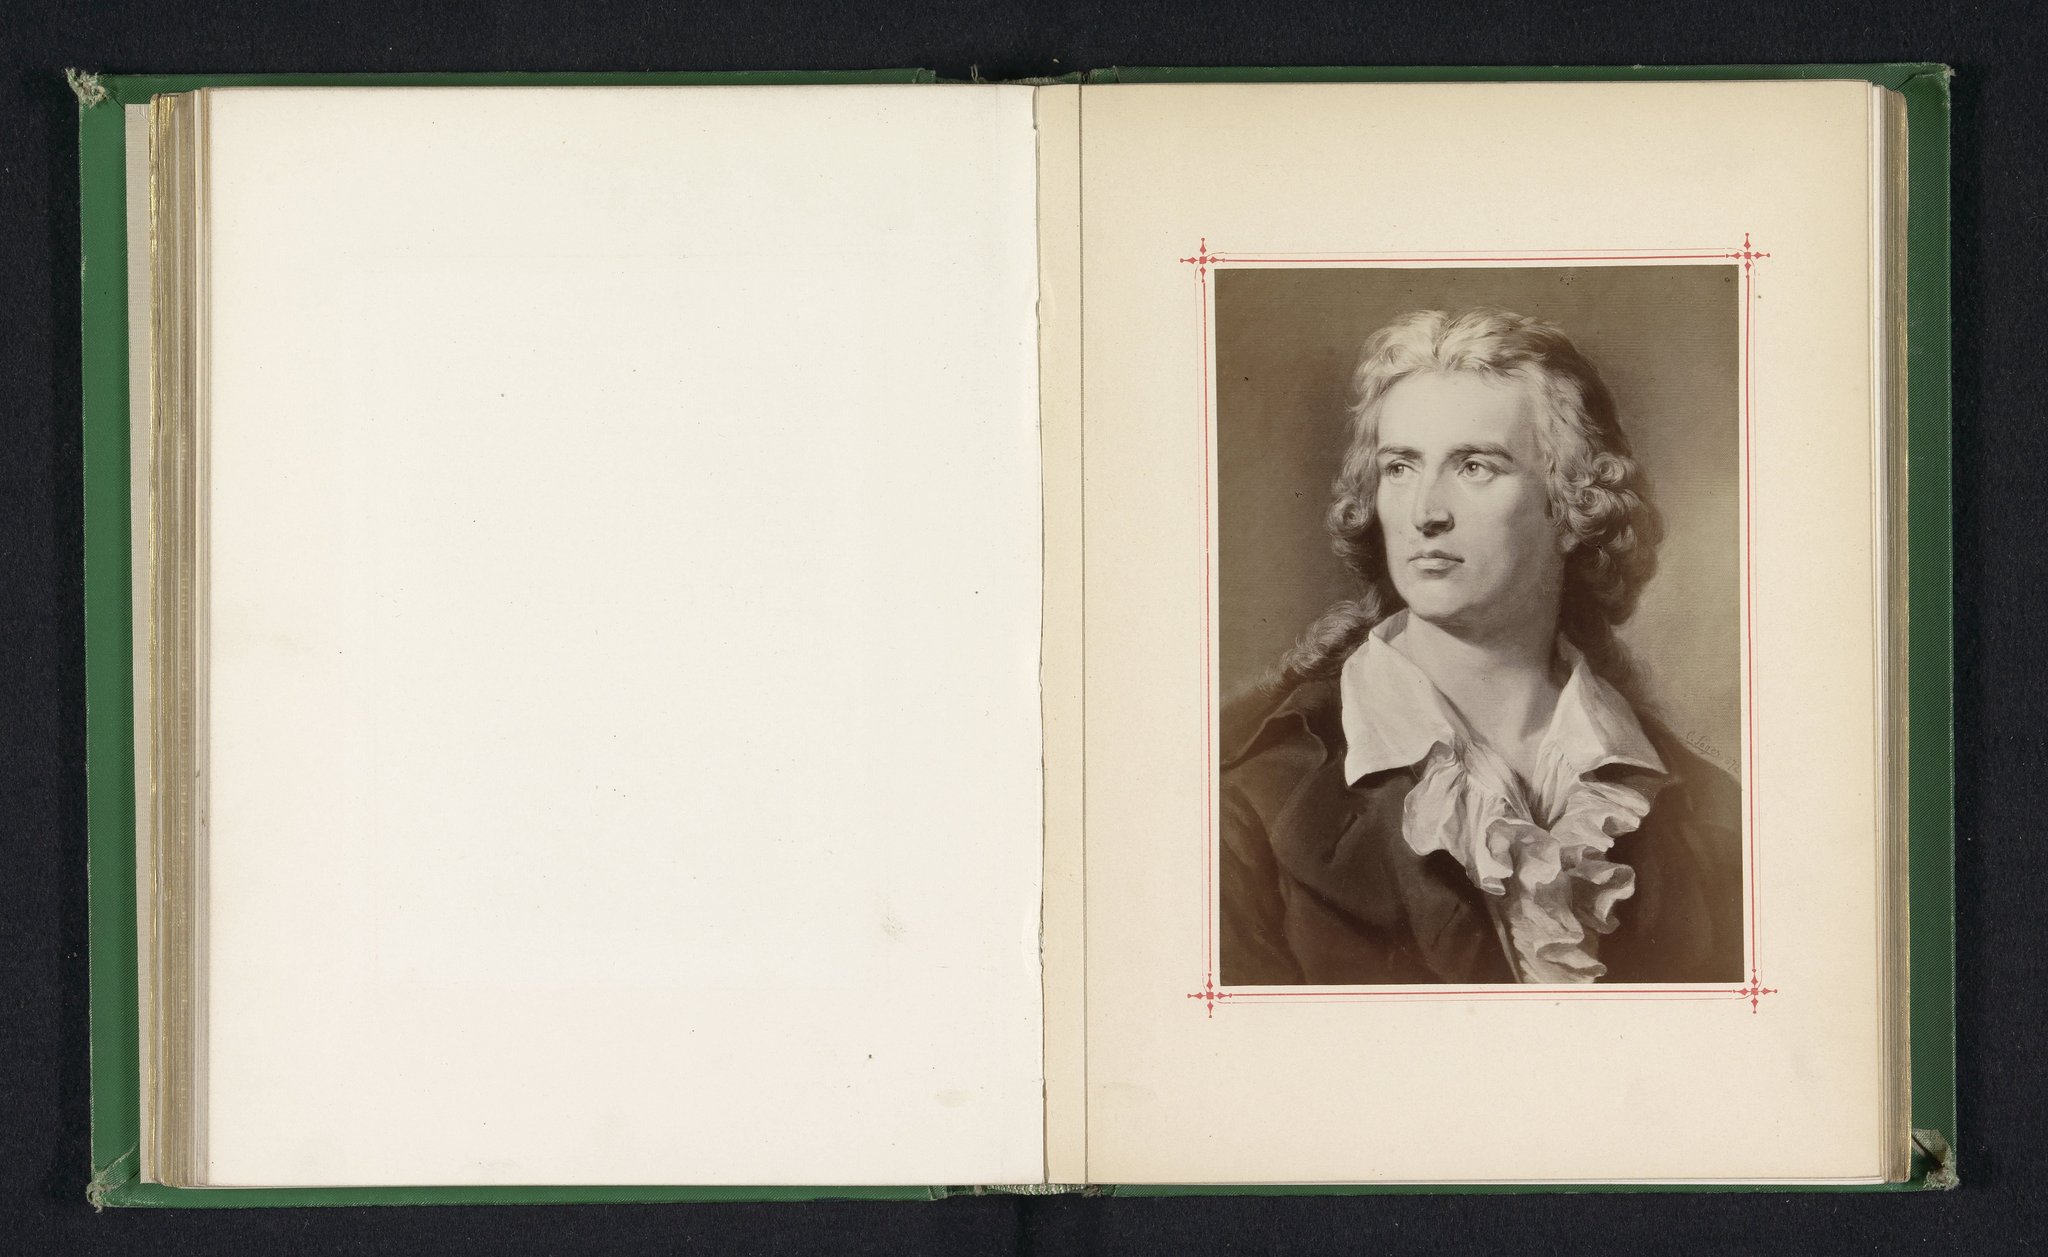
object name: page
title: Fotoreproductie van een portret van Friedrich von Schiller door Carl Jäger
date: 1868-1878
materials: photographic support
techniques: albumen print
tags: friedrich von schiller, writer, poet, author